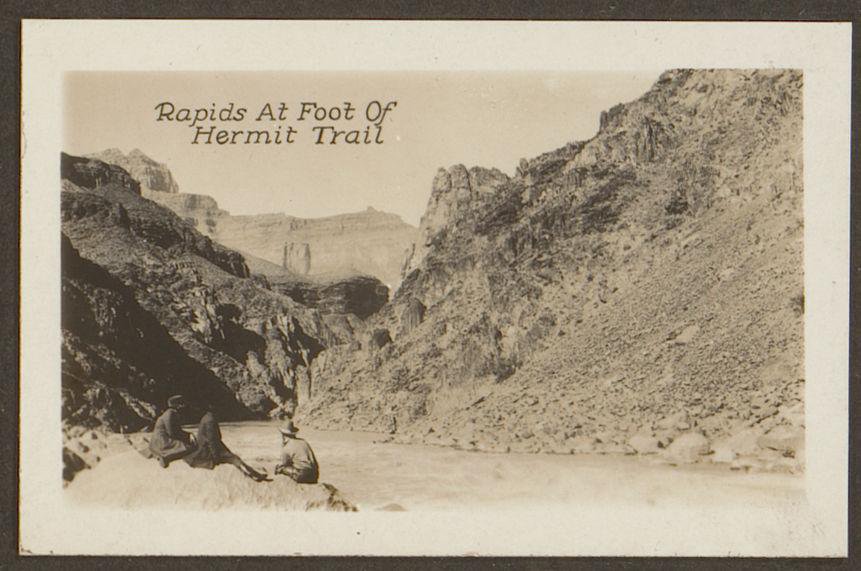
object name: album leaf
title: On the trail below Hermit Camp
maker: Anonymous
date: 1928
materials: photographic support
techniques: gelatin silver print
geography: united states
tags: ravine, chasm, abyss, canyon, road, path, rock-formations, united states of america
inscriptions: annotation: ‘Grand Canyon’